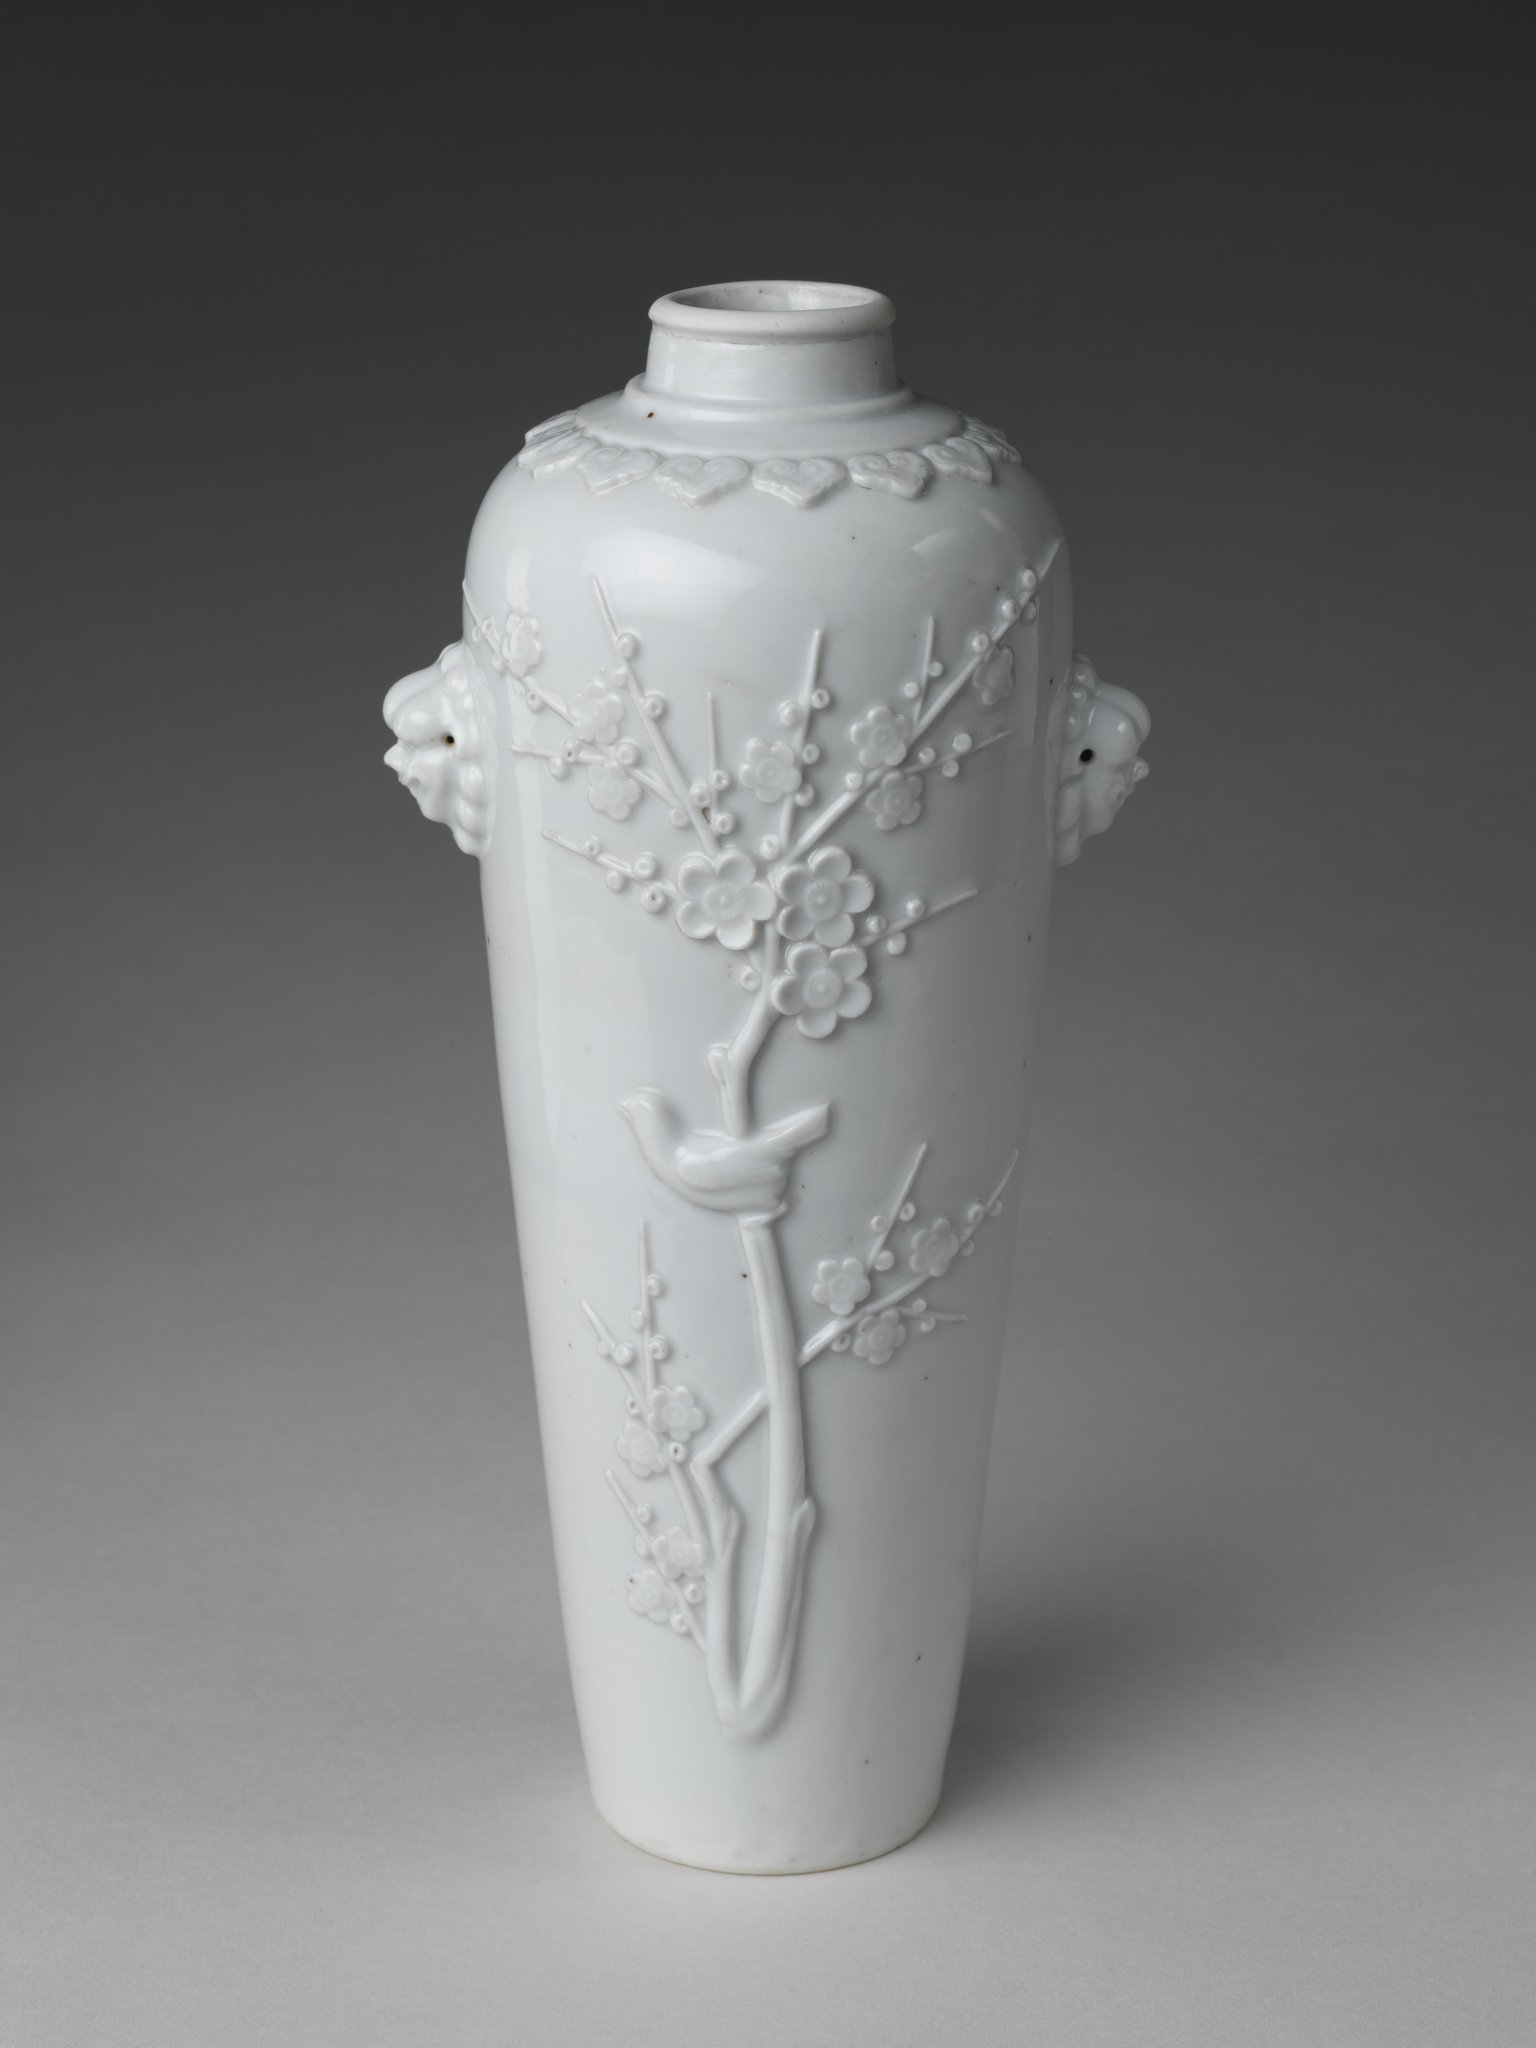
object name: vase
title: Vase with Plum Blossoms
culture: chinese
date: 1701-1800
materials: porcelain